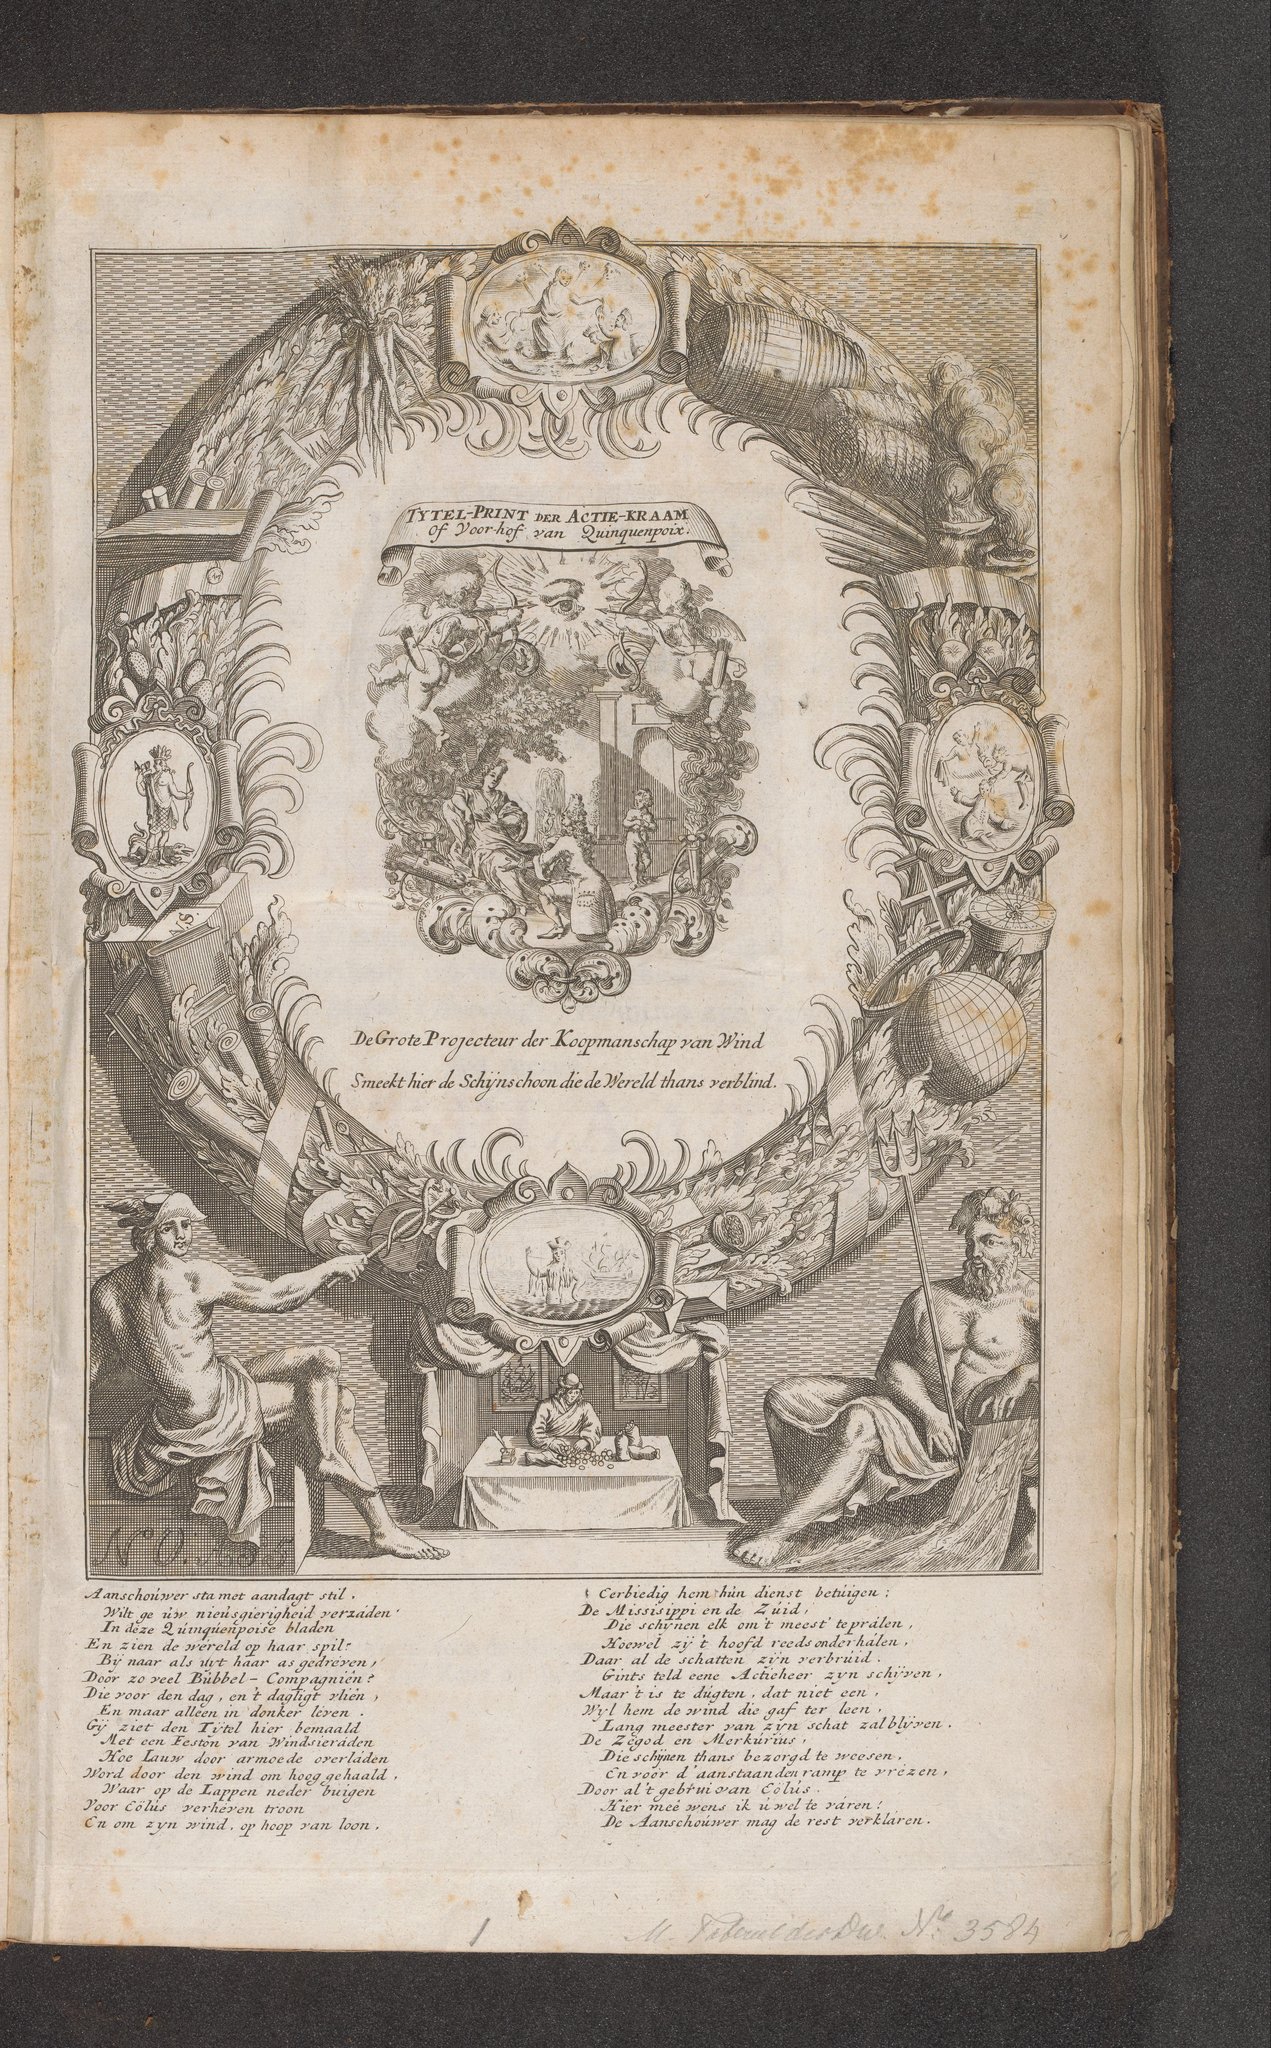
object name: cartoon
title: Tytel-Print der Actie-Kraam of Voor-hof van Quinquenpoix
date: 1697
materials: paper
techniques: engraving, etching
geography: northern netherlands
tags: being refused, the proposal rejected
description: Titelpagina met de Actiekraam of het Voorhof van Quinquenpoix. In de centrale voorstelling knielt een man met een liefdesverklaring voor een vrouw die hem afwijst (volgens de tekst: John Law en Schoonschijn), in de omlijsting cupido's en pijlenkokers. Met twee regels in het onderschrift. Deze plaat is afgedrukt in het midden van een grotere plaat met een krans opgebouwd uit allerlei voorwerpen die met de windhandel te maken hebben. Onderaan zitten Mercurius en Neptunus. In de plaat een onderschrift met twee verzen. Titelpagina in de gebonden vierde uitgave (304 B 12) van Het Groote Tafereel der Dwaasheid met spotprenten op de Windhandel of Actiehandel van 1720.